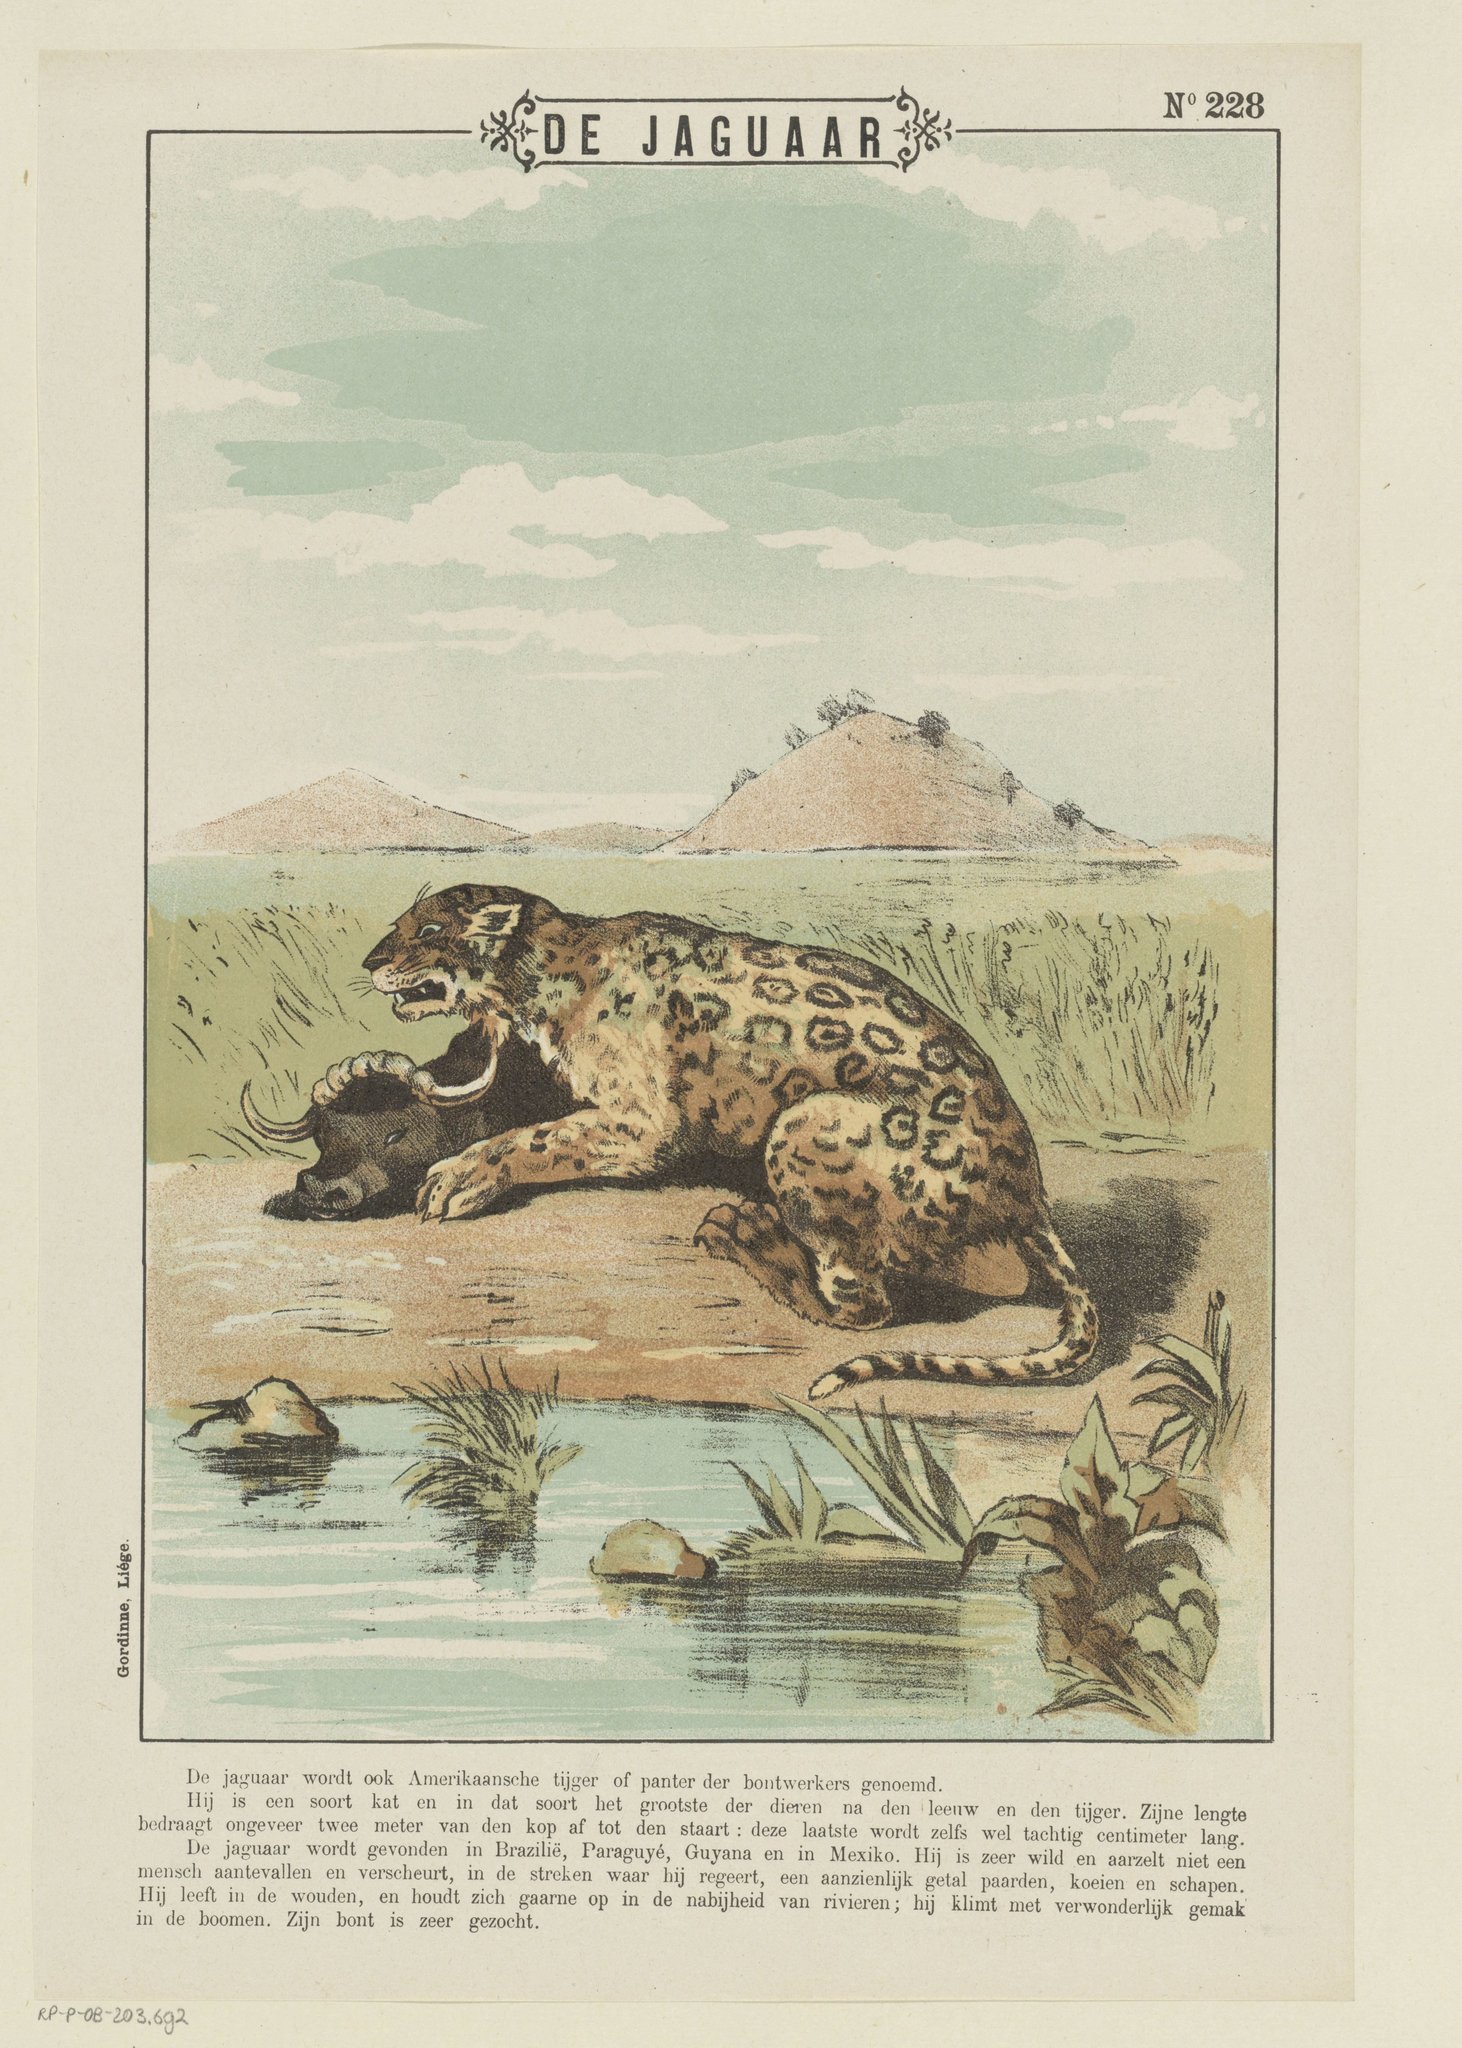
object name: popular print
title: De jaguaar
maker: Anonymous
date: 1894-1959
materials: paper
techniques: lithograph, letterpress printing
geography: liège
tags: beasts of prey, predatory animals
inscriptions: collector's mark: Lugt 2760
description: Blad met een grote voorstelling van een jaguar die een buffel gevangen heeft. In de ondermarge een onderschrift. Genummerd rechtsboven: No 228.